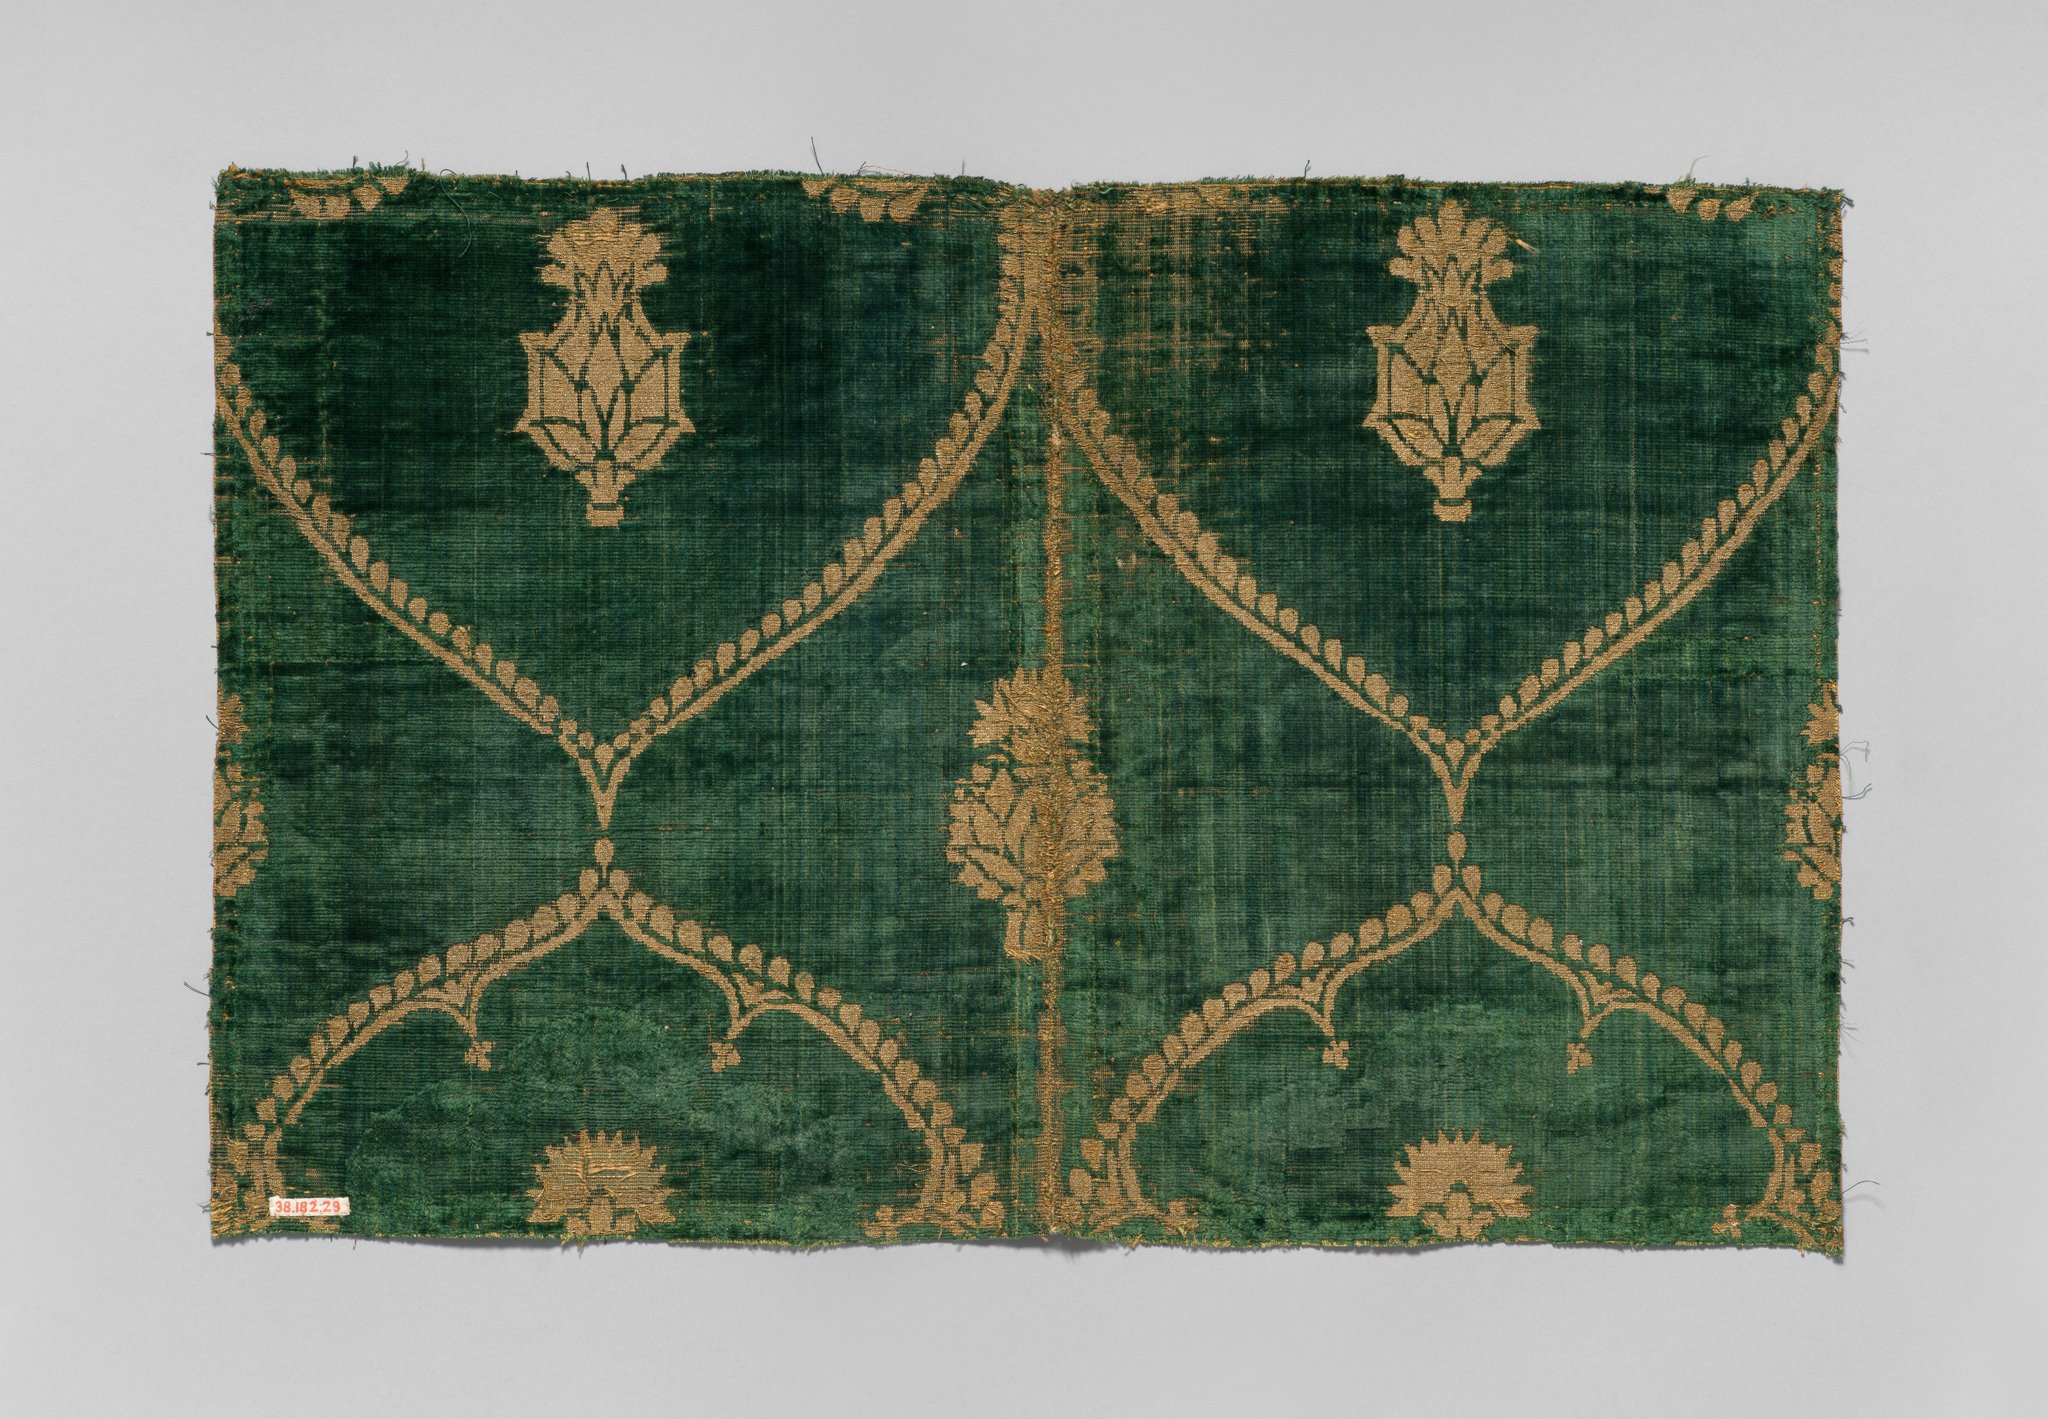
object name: piece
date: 1434-1466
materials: metal thread, silk